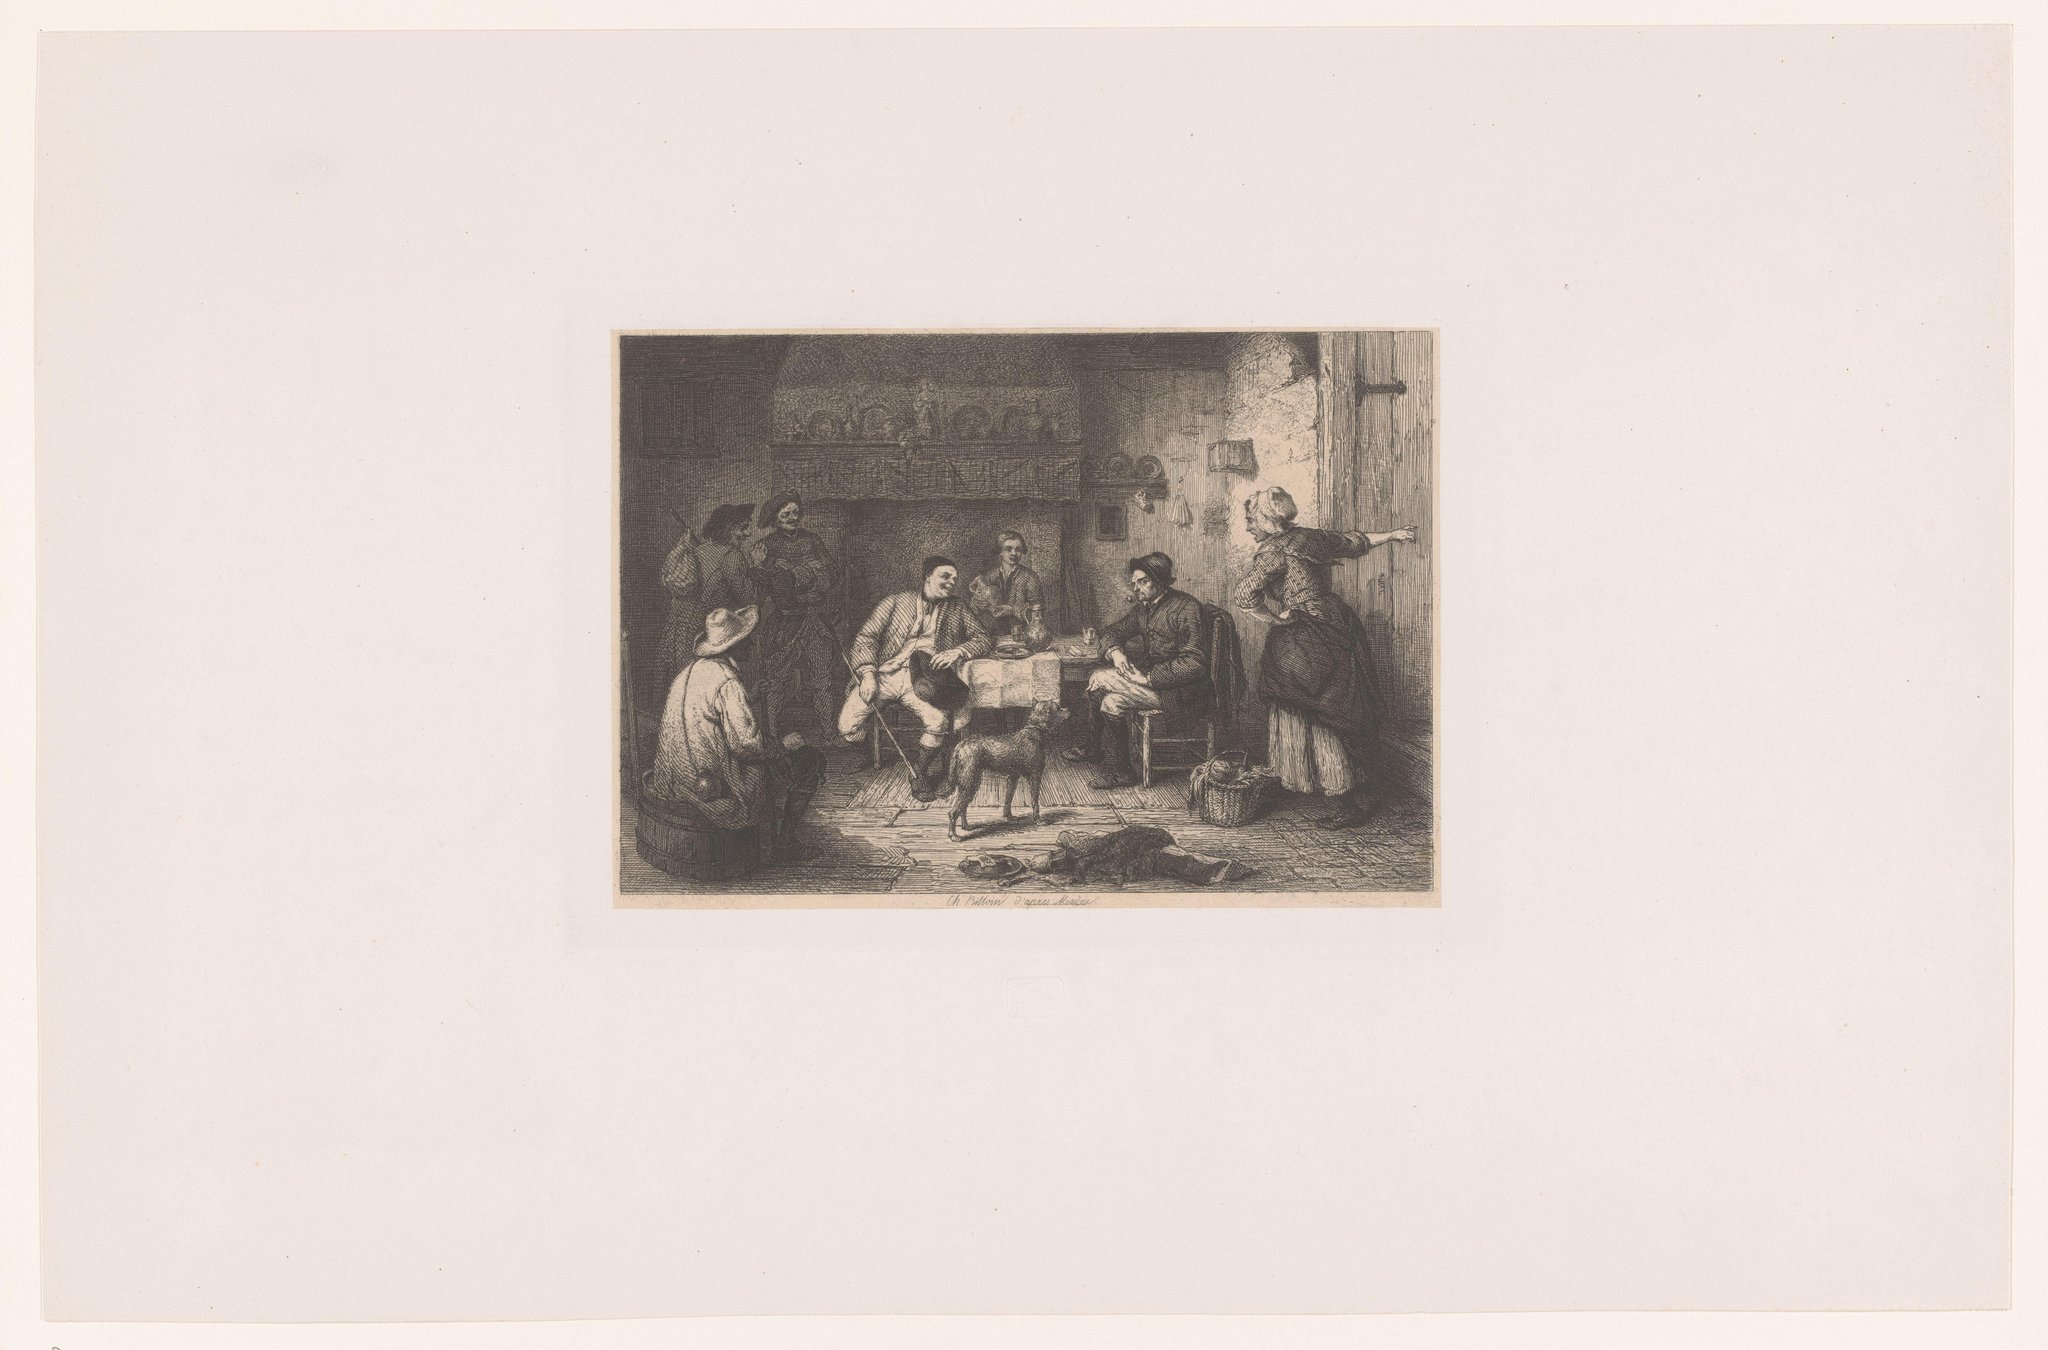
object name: print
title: Boze vrouw wijst mannen in een herberg de deur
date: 1850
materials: paper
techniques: etching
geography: brussels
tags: pipe ~ tobacco, quarrel, argument, hotel, hostelry, inn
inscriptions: collector's mark: Lugt 2228, collector's mark: Lugt 2165, check stamp: ‘L. Déro-Becker. / Fils / éditeur / Bruxelles’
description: Prent uit: Les peintres Belges au XIXe siècle. Brussel: Déro-Becker fils, 1850. Deze suite bevat zes prenten van Billoin naar Madou.